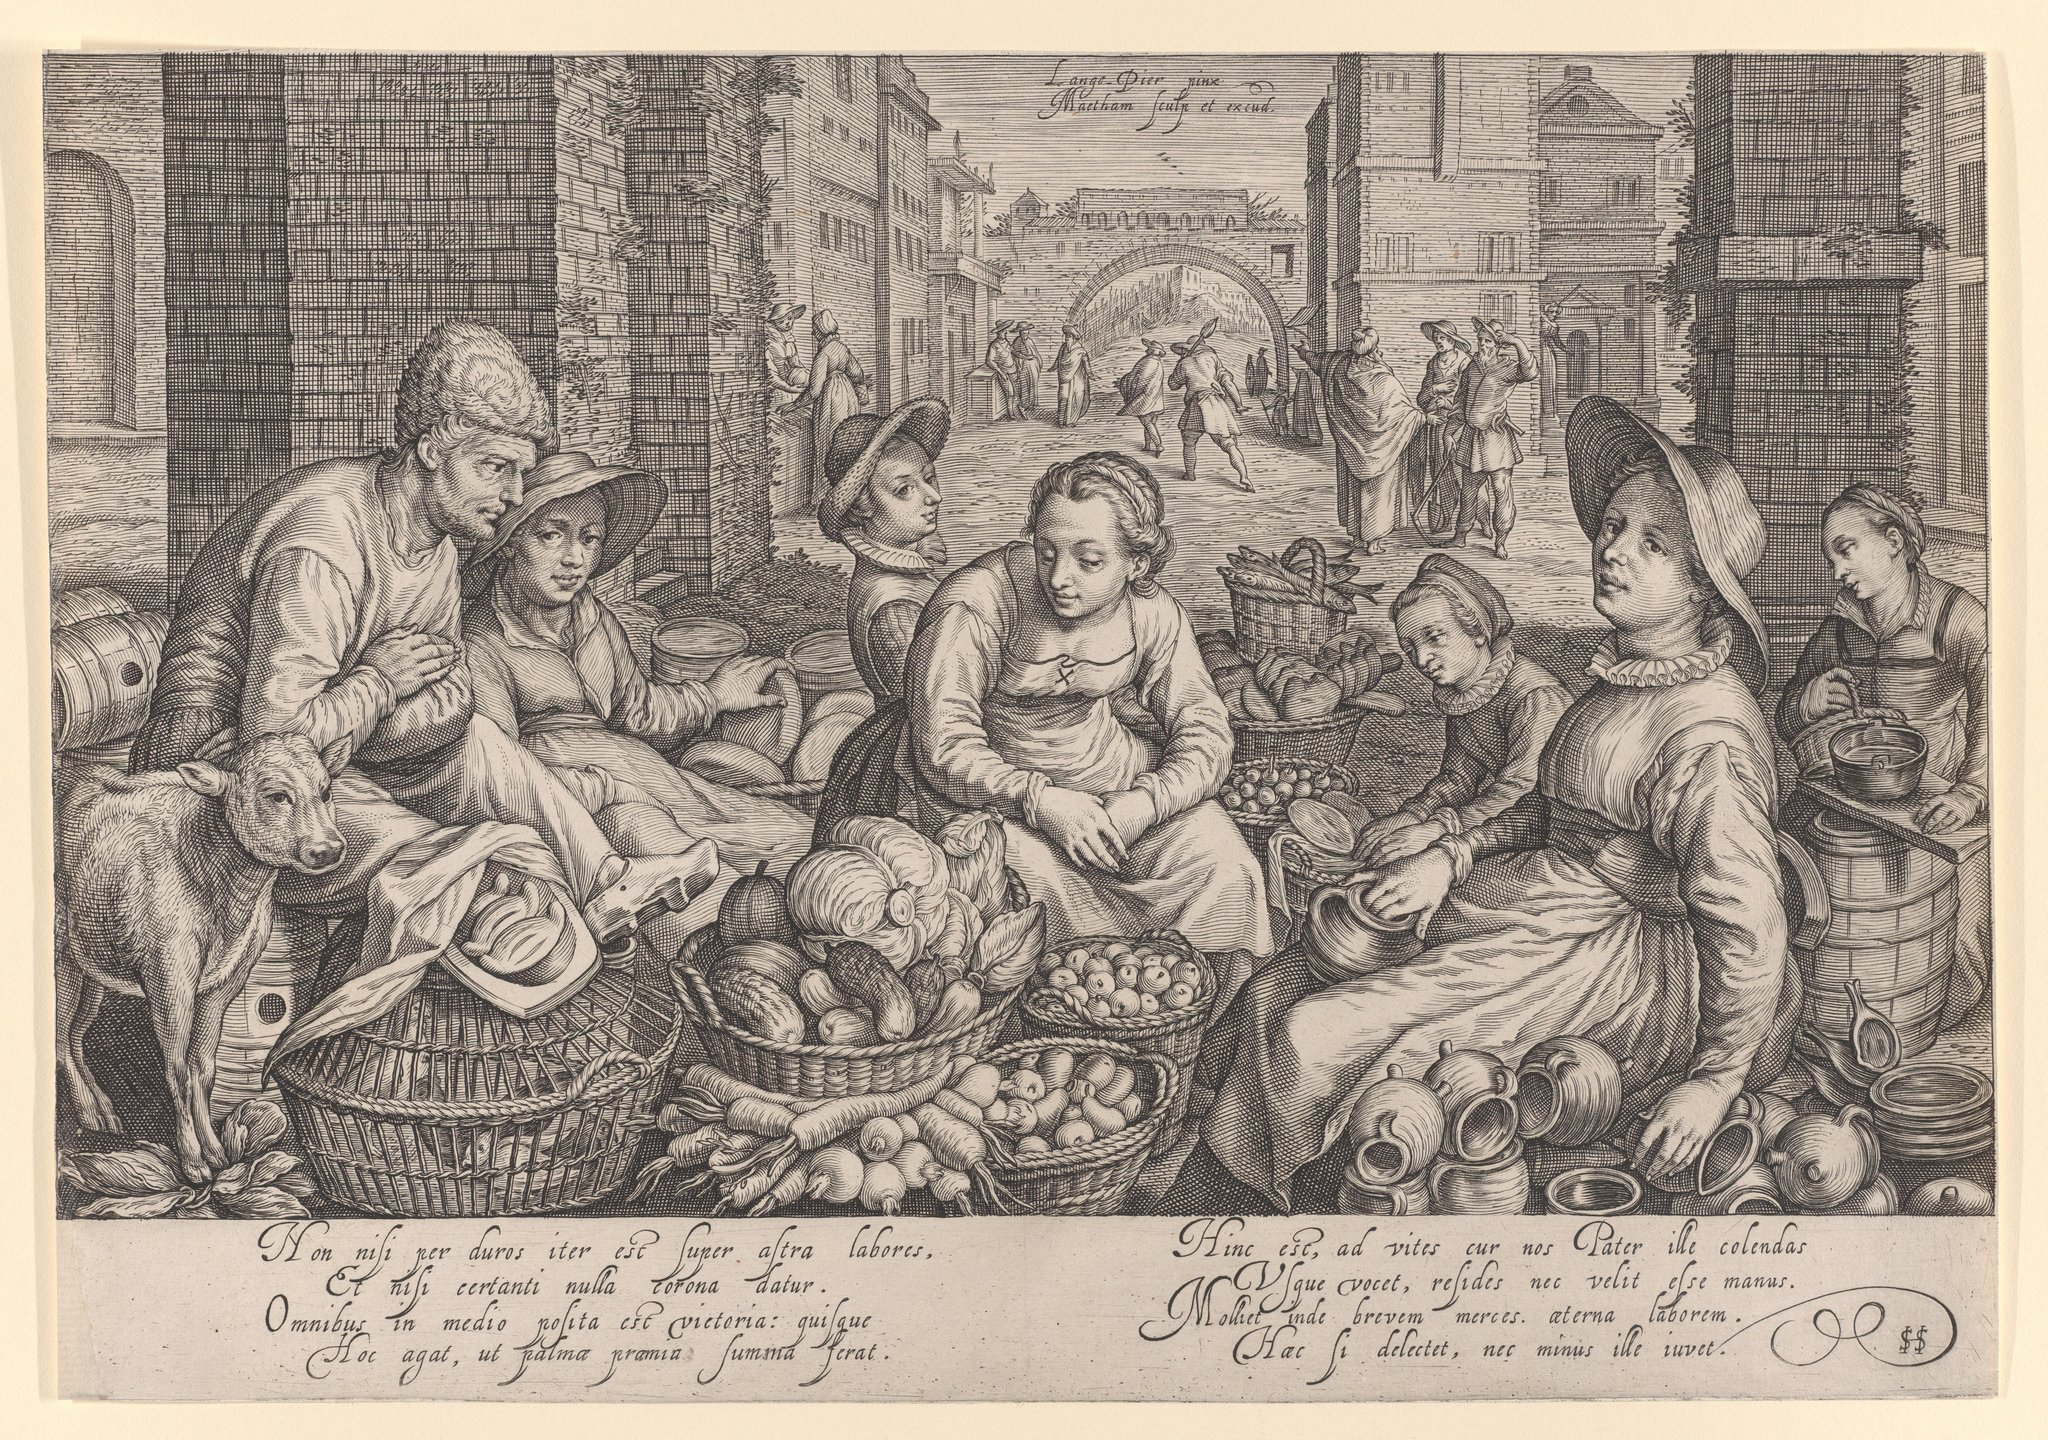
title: Market Scene in City with the Parable of the Laborers in the Vineyard in the Background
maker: jacob matham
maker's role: artist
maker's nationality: netherlandish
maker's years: 1571-1631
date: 1603